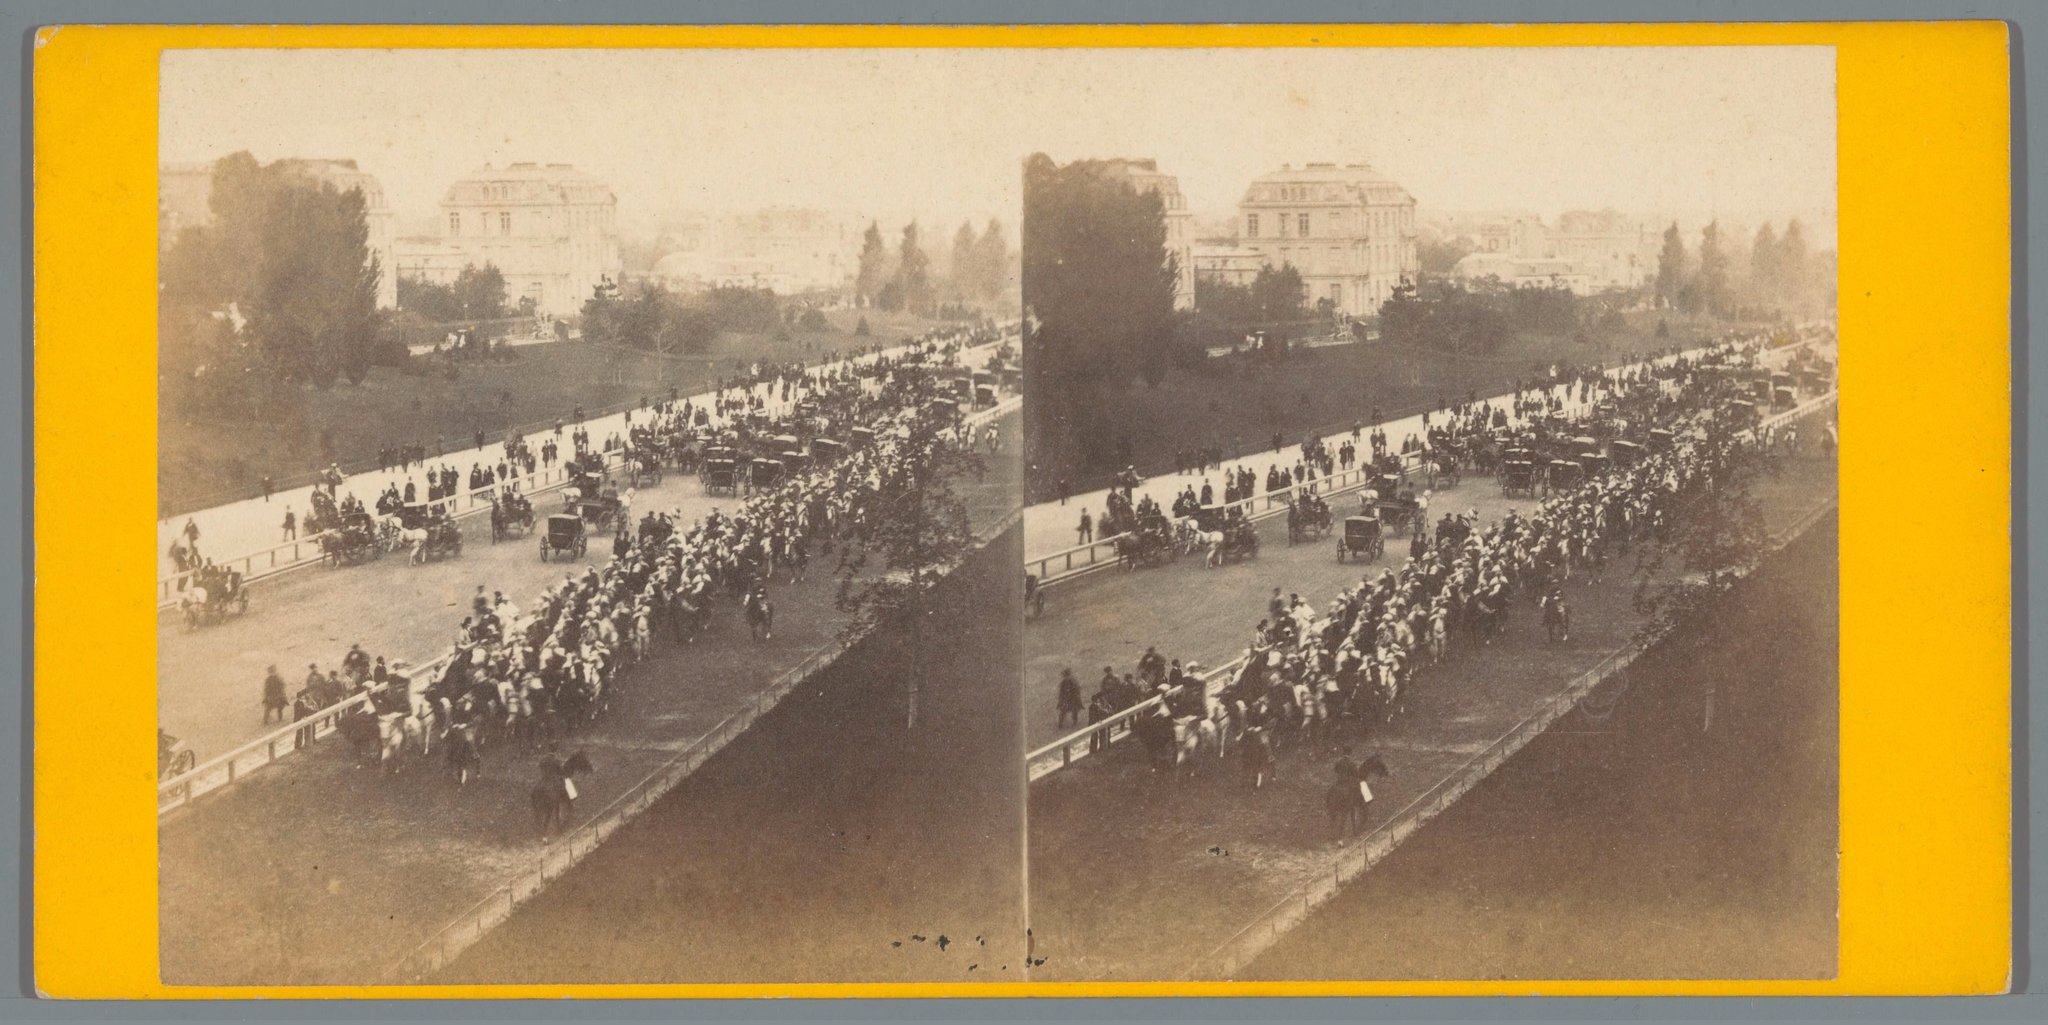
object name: stereograph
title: Avenue de l'Imperatrice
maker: Anonymous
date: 1850-1870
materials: cardboard, photographic support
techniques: albumen print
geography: paris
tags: animal traction, animal-drawn vehicle (carriage etc.), street